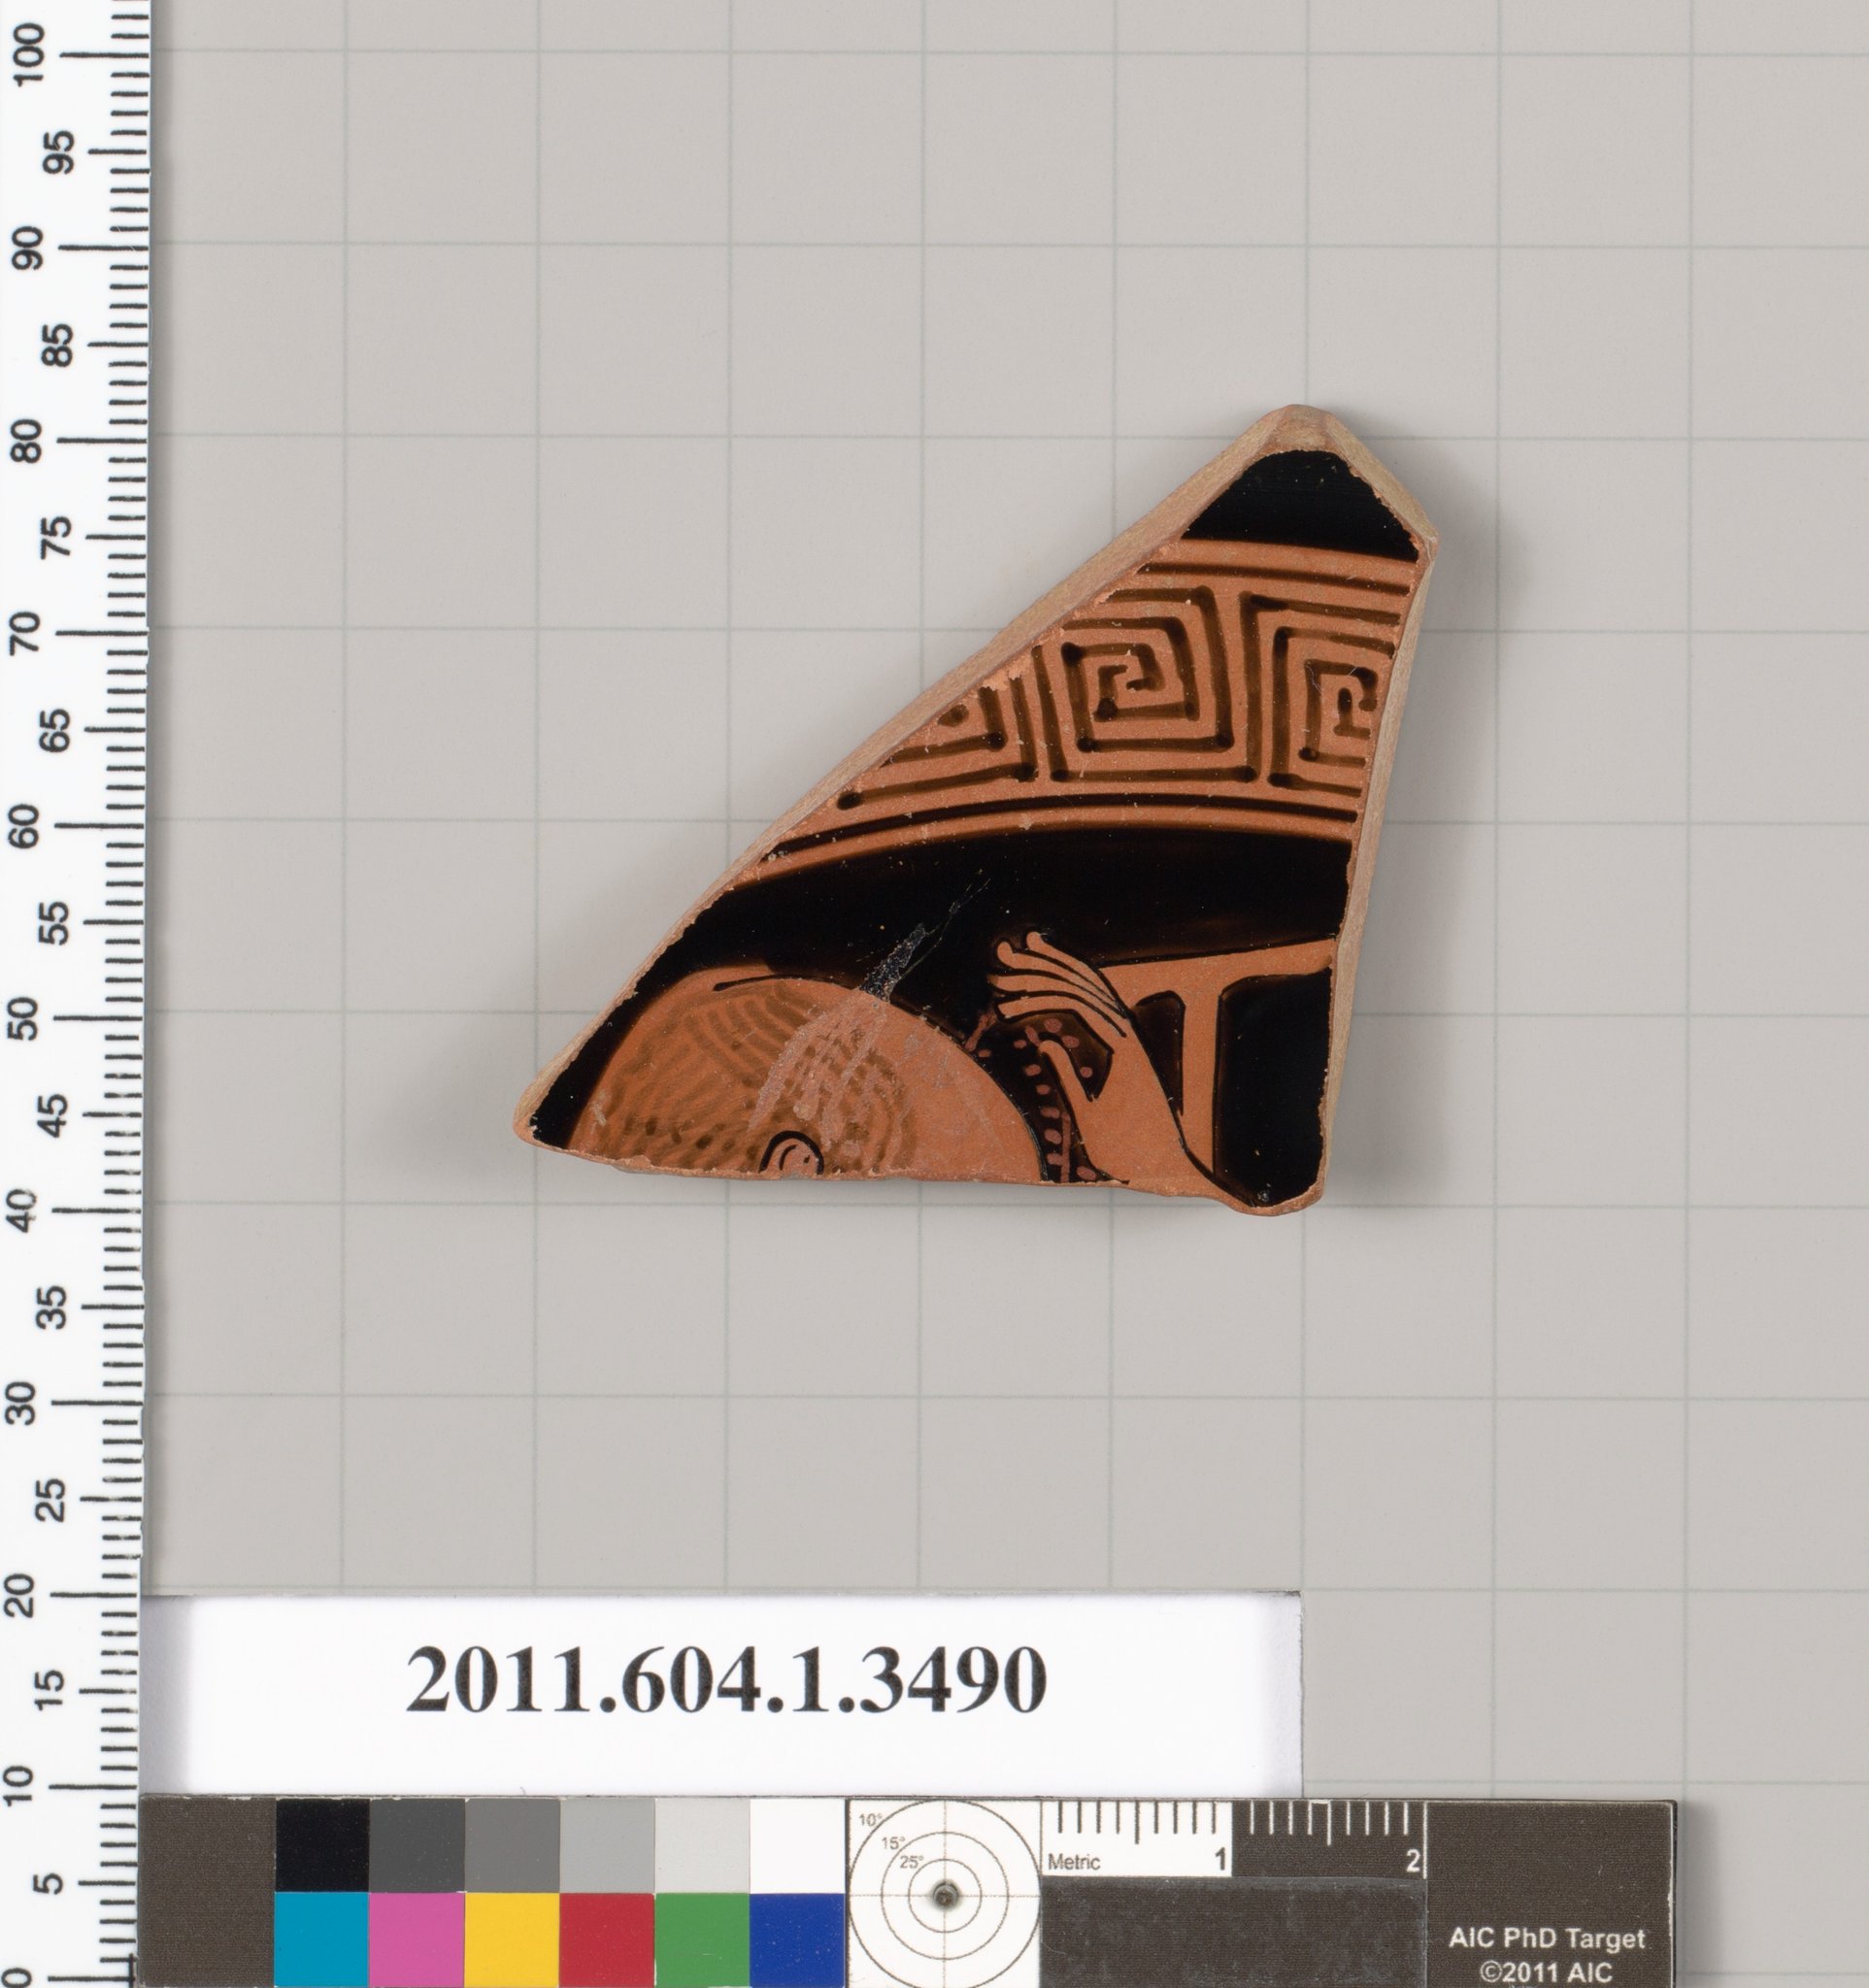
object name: kylix fragment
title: Terracotta fragment of a kylix (drinking cup)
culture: greek, attic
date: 490-480 BCE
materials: terracotta